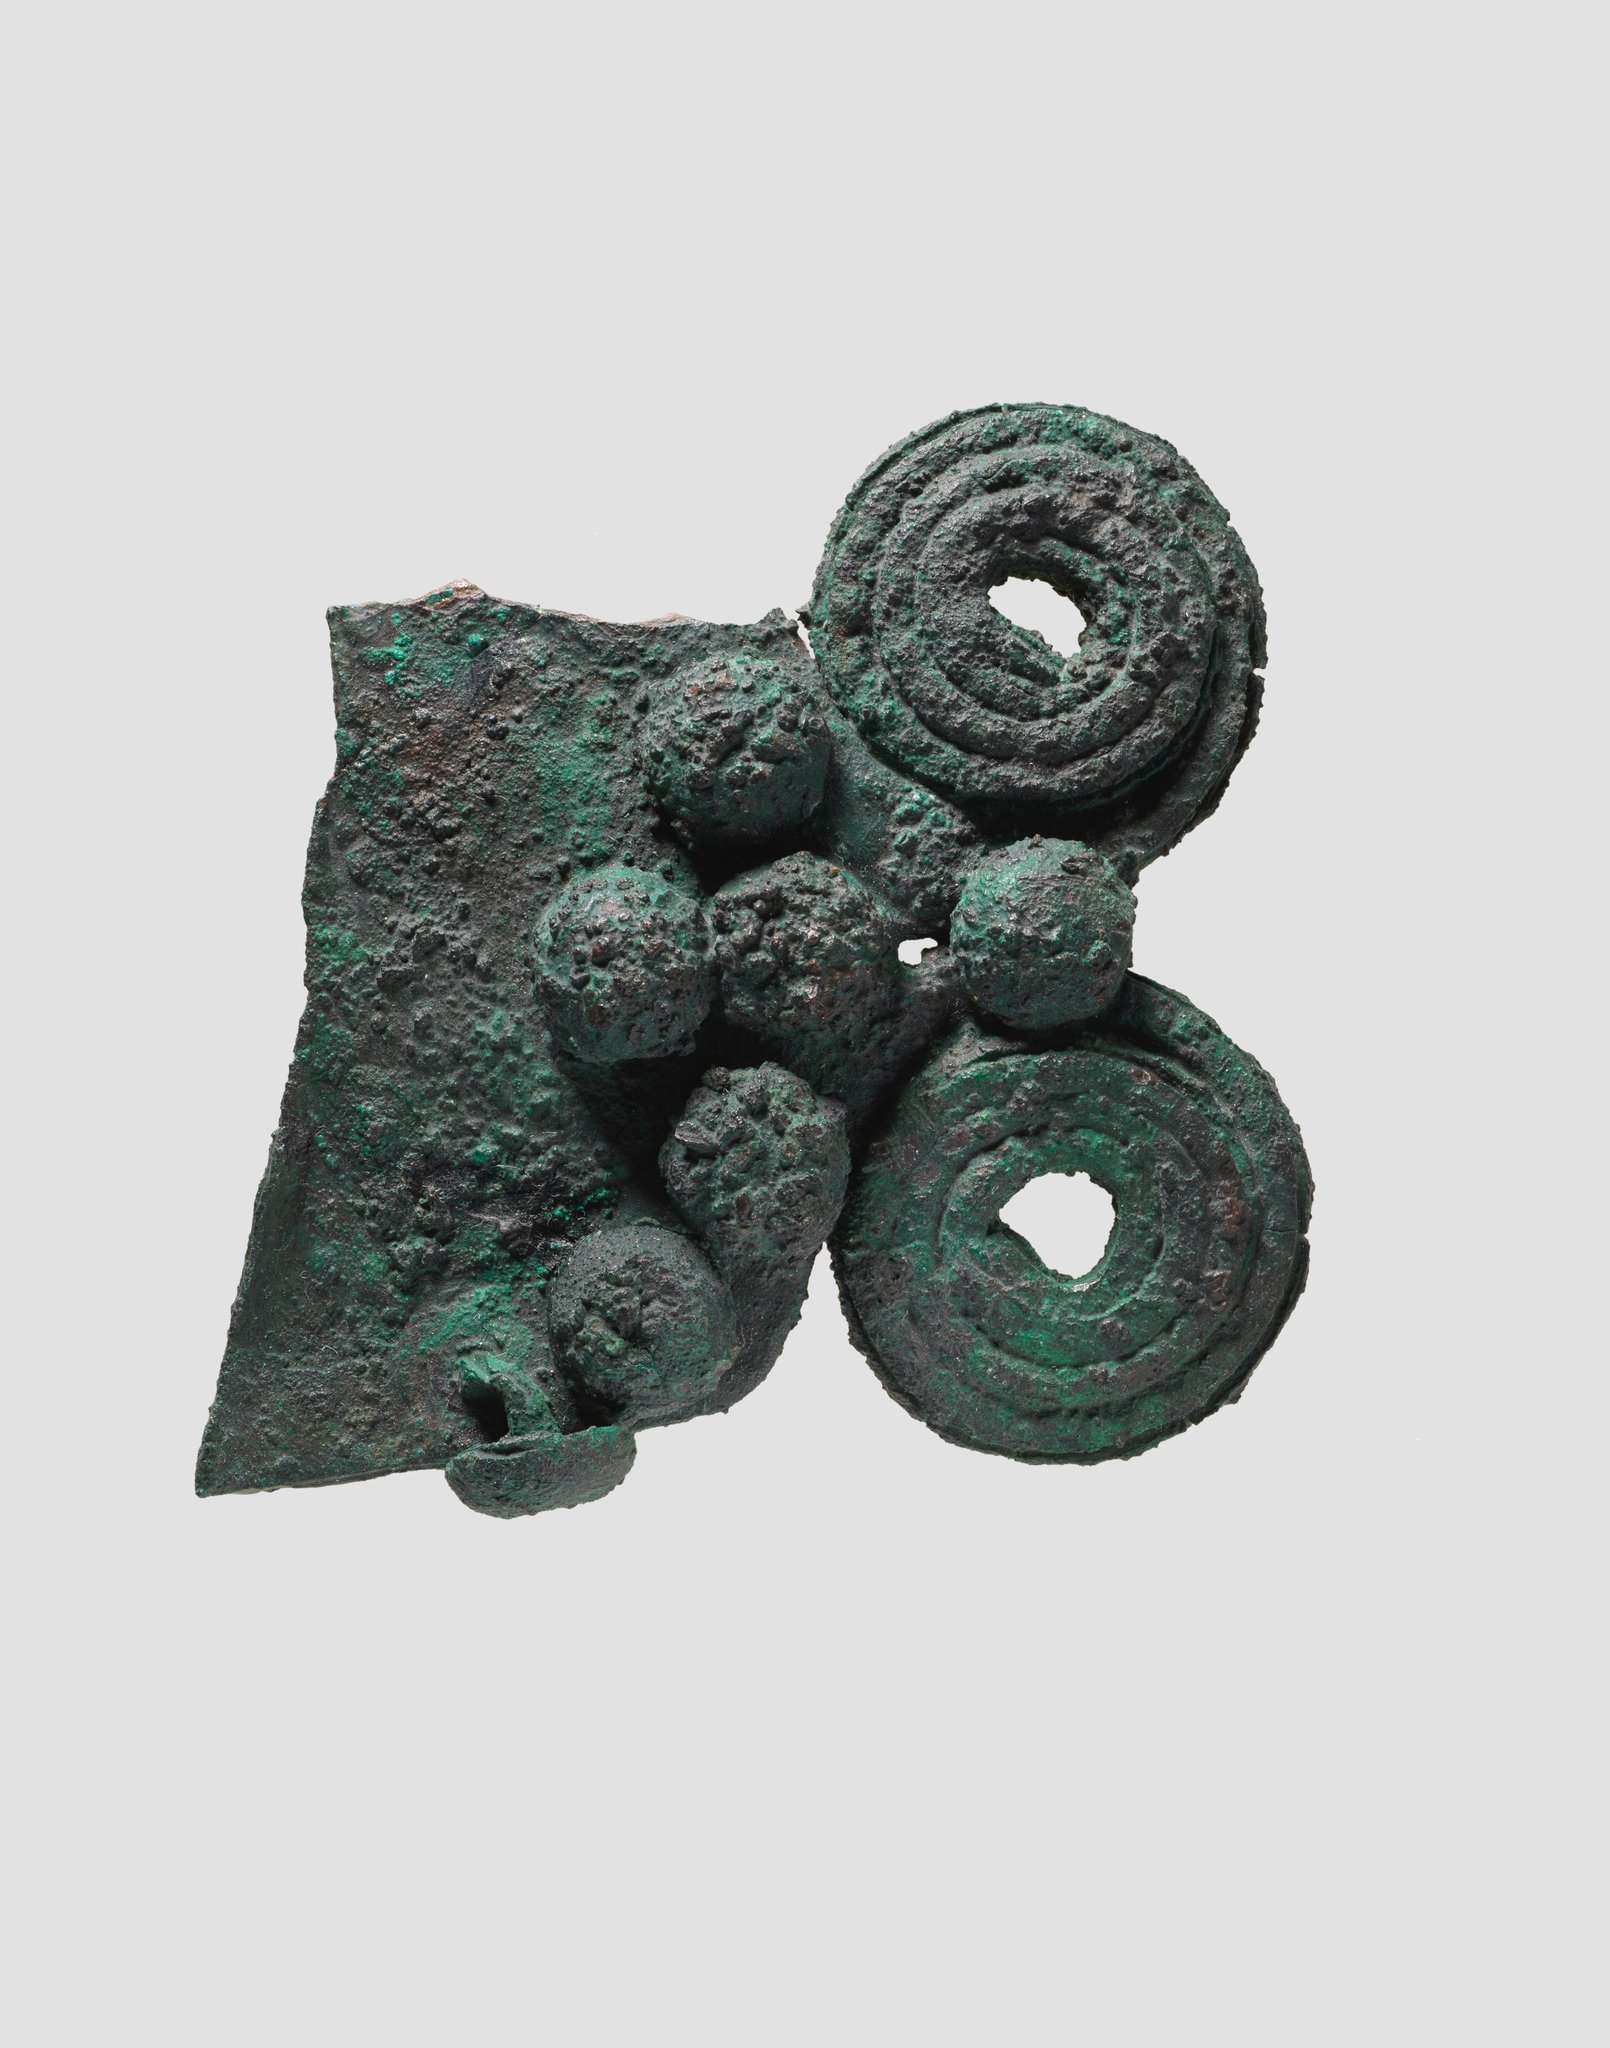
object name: belt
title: Belt fragment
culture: iranian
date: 900-801 BCE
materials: bronze, copper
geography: iran